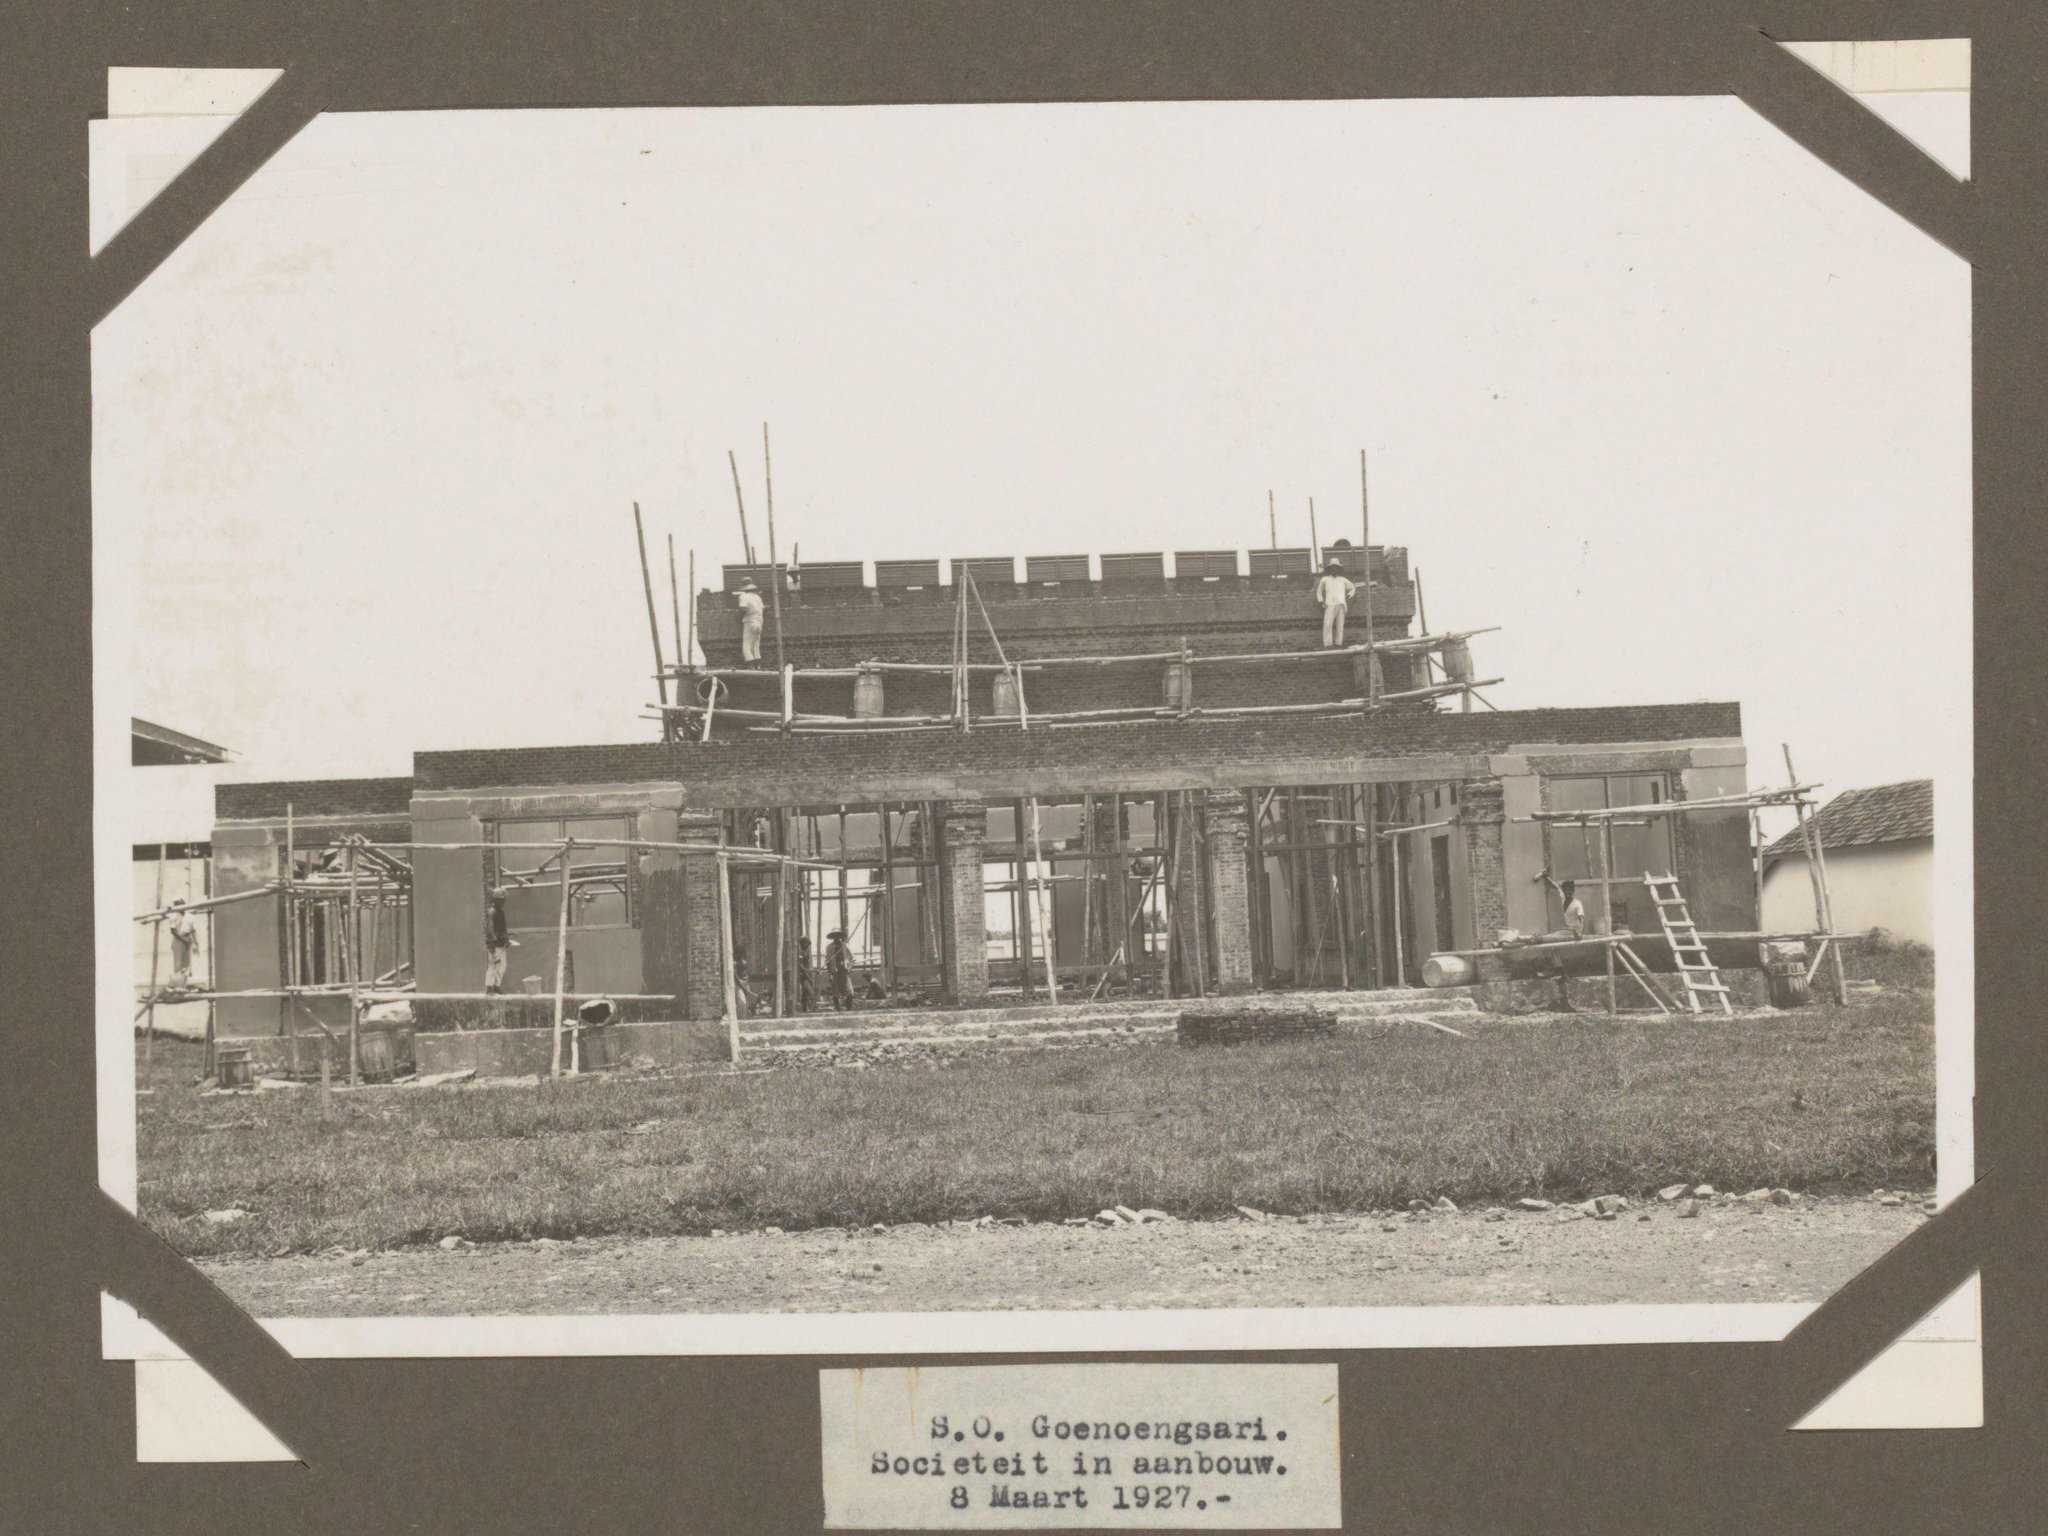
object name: photograph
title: S.O. Goenoengsari. Societeit in aanbouw. 8 Maart 1927.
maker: Anonymous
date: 1903-1927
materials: photographic support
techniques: gelatin silver print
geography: east java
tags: colonial system, club, meeting place, trade-company, making the overground structures (~ building activities), (non-fruit) products of plants or trees: sugarcane, exterior of industrial structures, factories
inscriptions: inscription: ‘S.O. Goenoengsari. Societeit in aanbouw. 8 Maart 1927.’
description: Het gebouw voor de sociëteit van de fabriek in aanbouw, 8 maart 1927. Onderdeel van het fotoalbum met foto's van de opbouw van de suikerfabriek te Goenoengsari op Oost-Java door de Handels Vereniging Amsterdam 1926-1927.